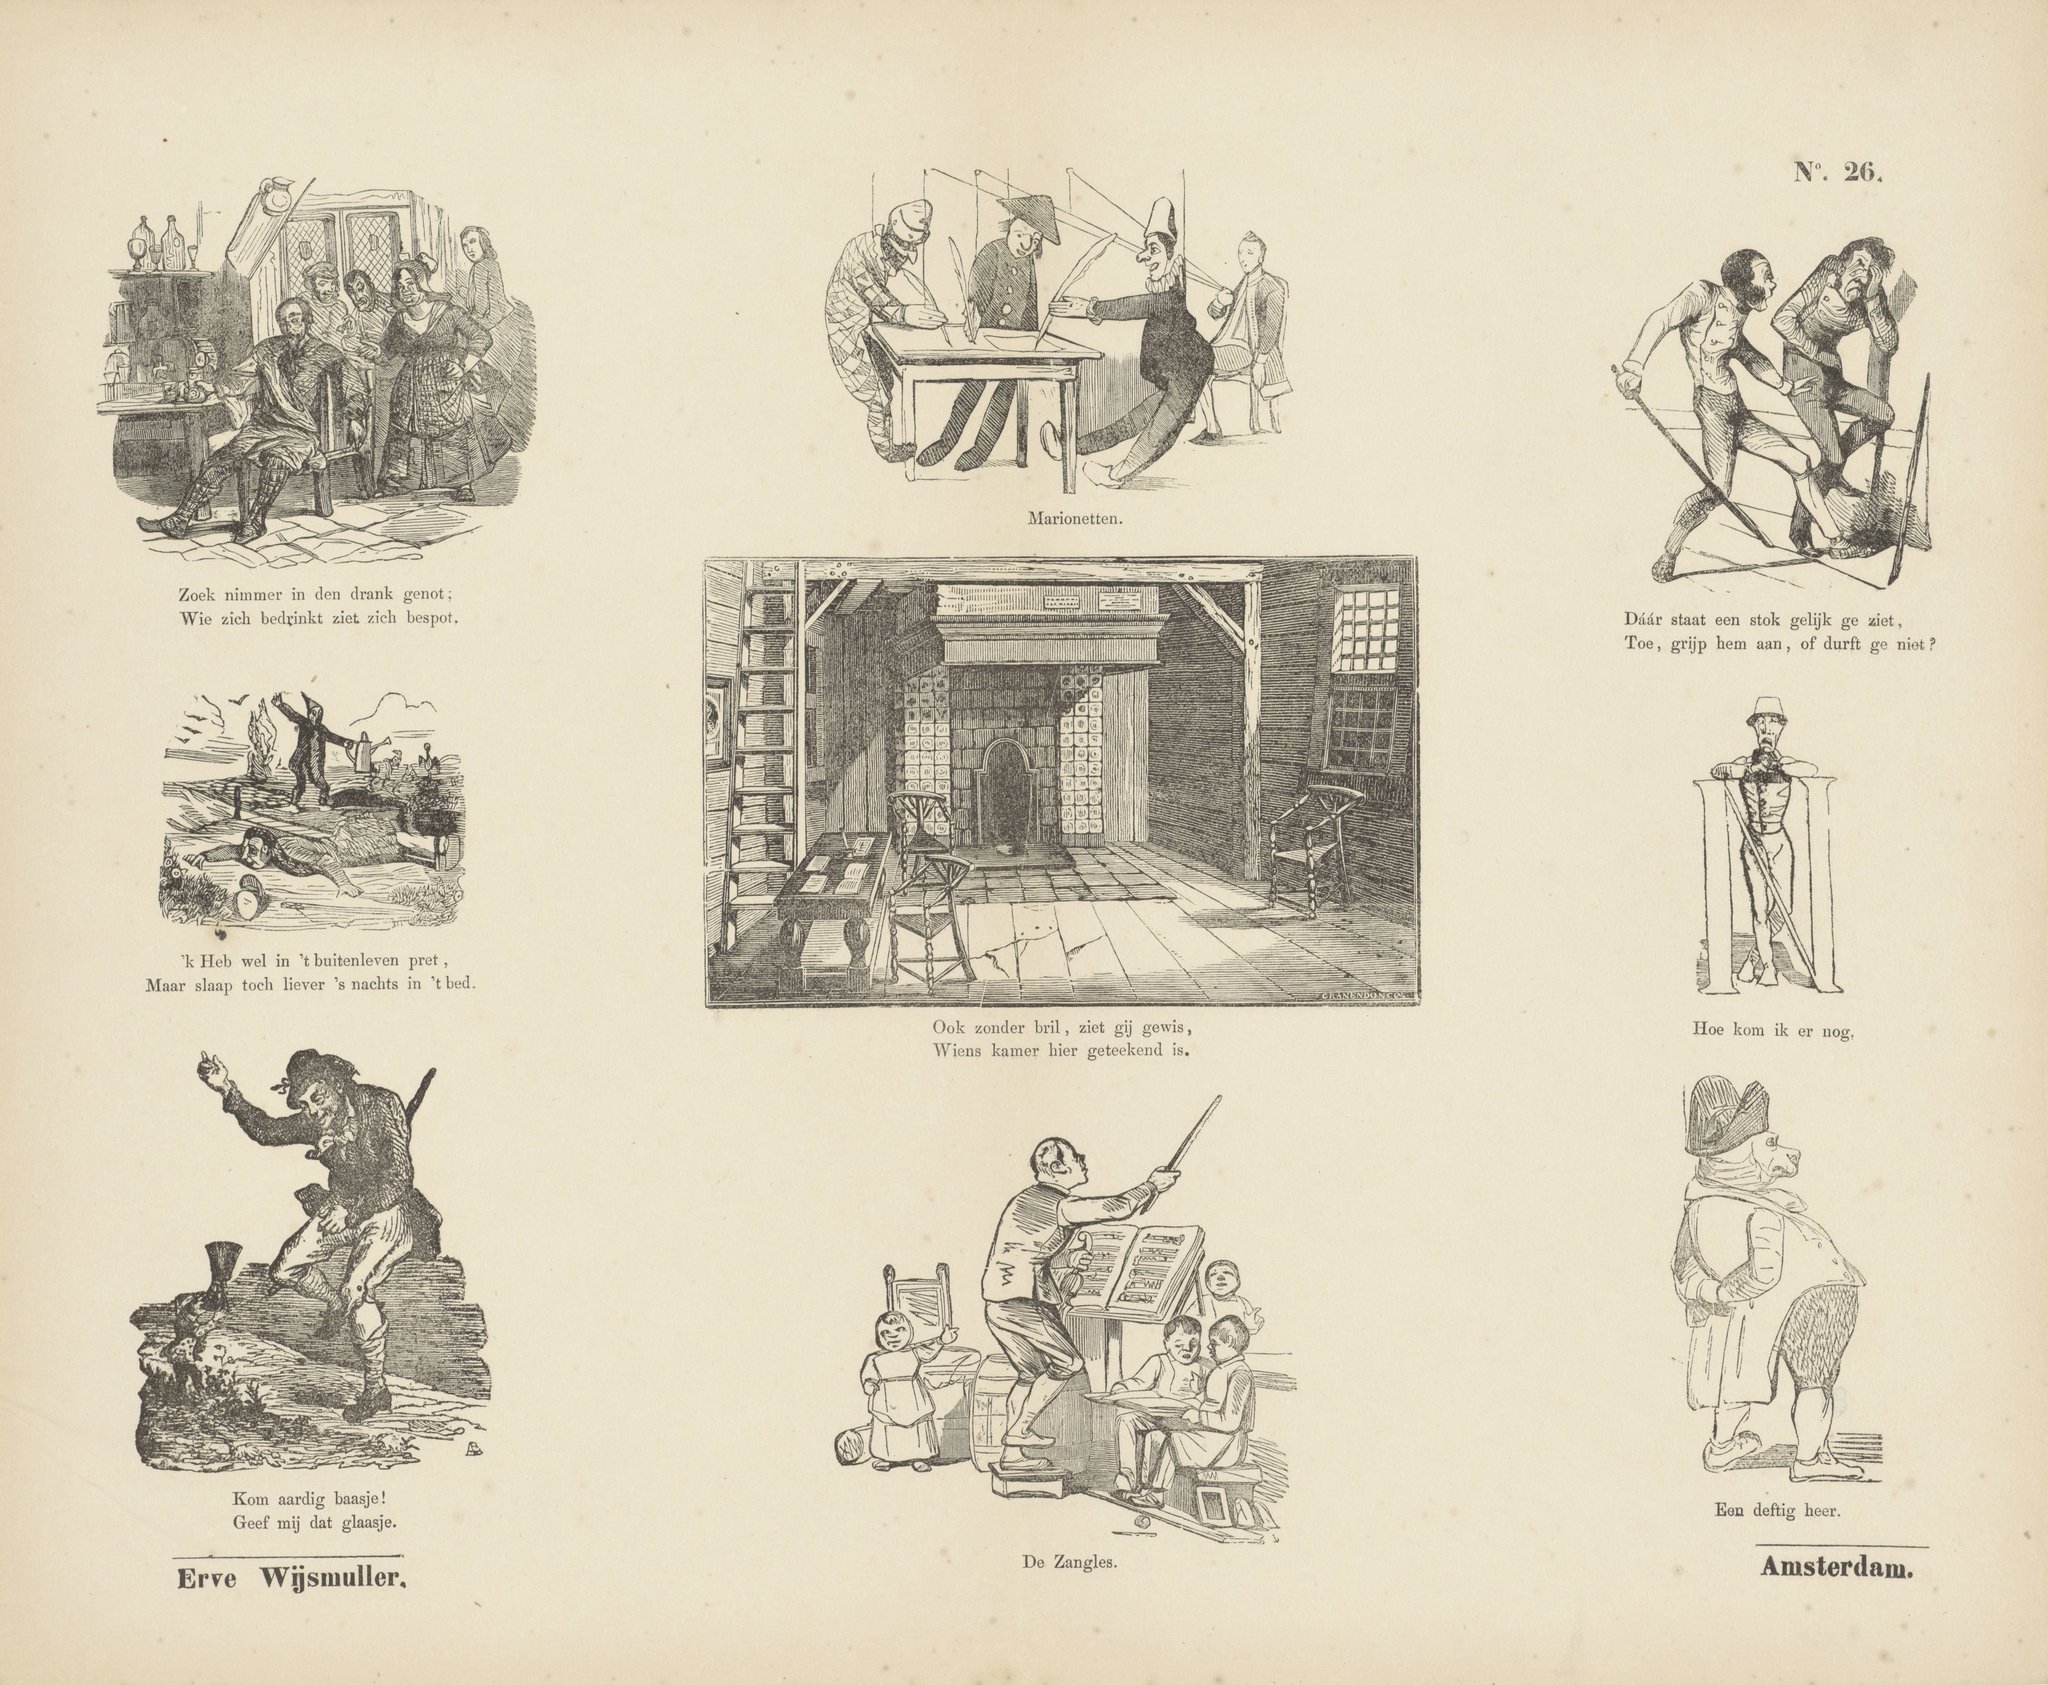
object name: print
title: Verschillende voorstellingen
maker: Anonymous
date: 1828-1913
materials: paper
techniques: letterpress printing, line block, engraving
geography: netherlands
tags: marionette, drunkard, vocal music, singing, interior of the house, drunkenness, children singing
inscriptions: collector's mark: Lugt 2760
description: Blad met 9 voorstellingen van verschillende aard, waaronder marionetten, een zangles en een deftige heer. Onder elke afbeelding een onderschrift. Onder de eerste afbeelding het onderschrift: Zoek nimmer in den drank genot; / Wie zich bedrinkt ziet zich bespot. Genummerd rechtsboven: No. 26.